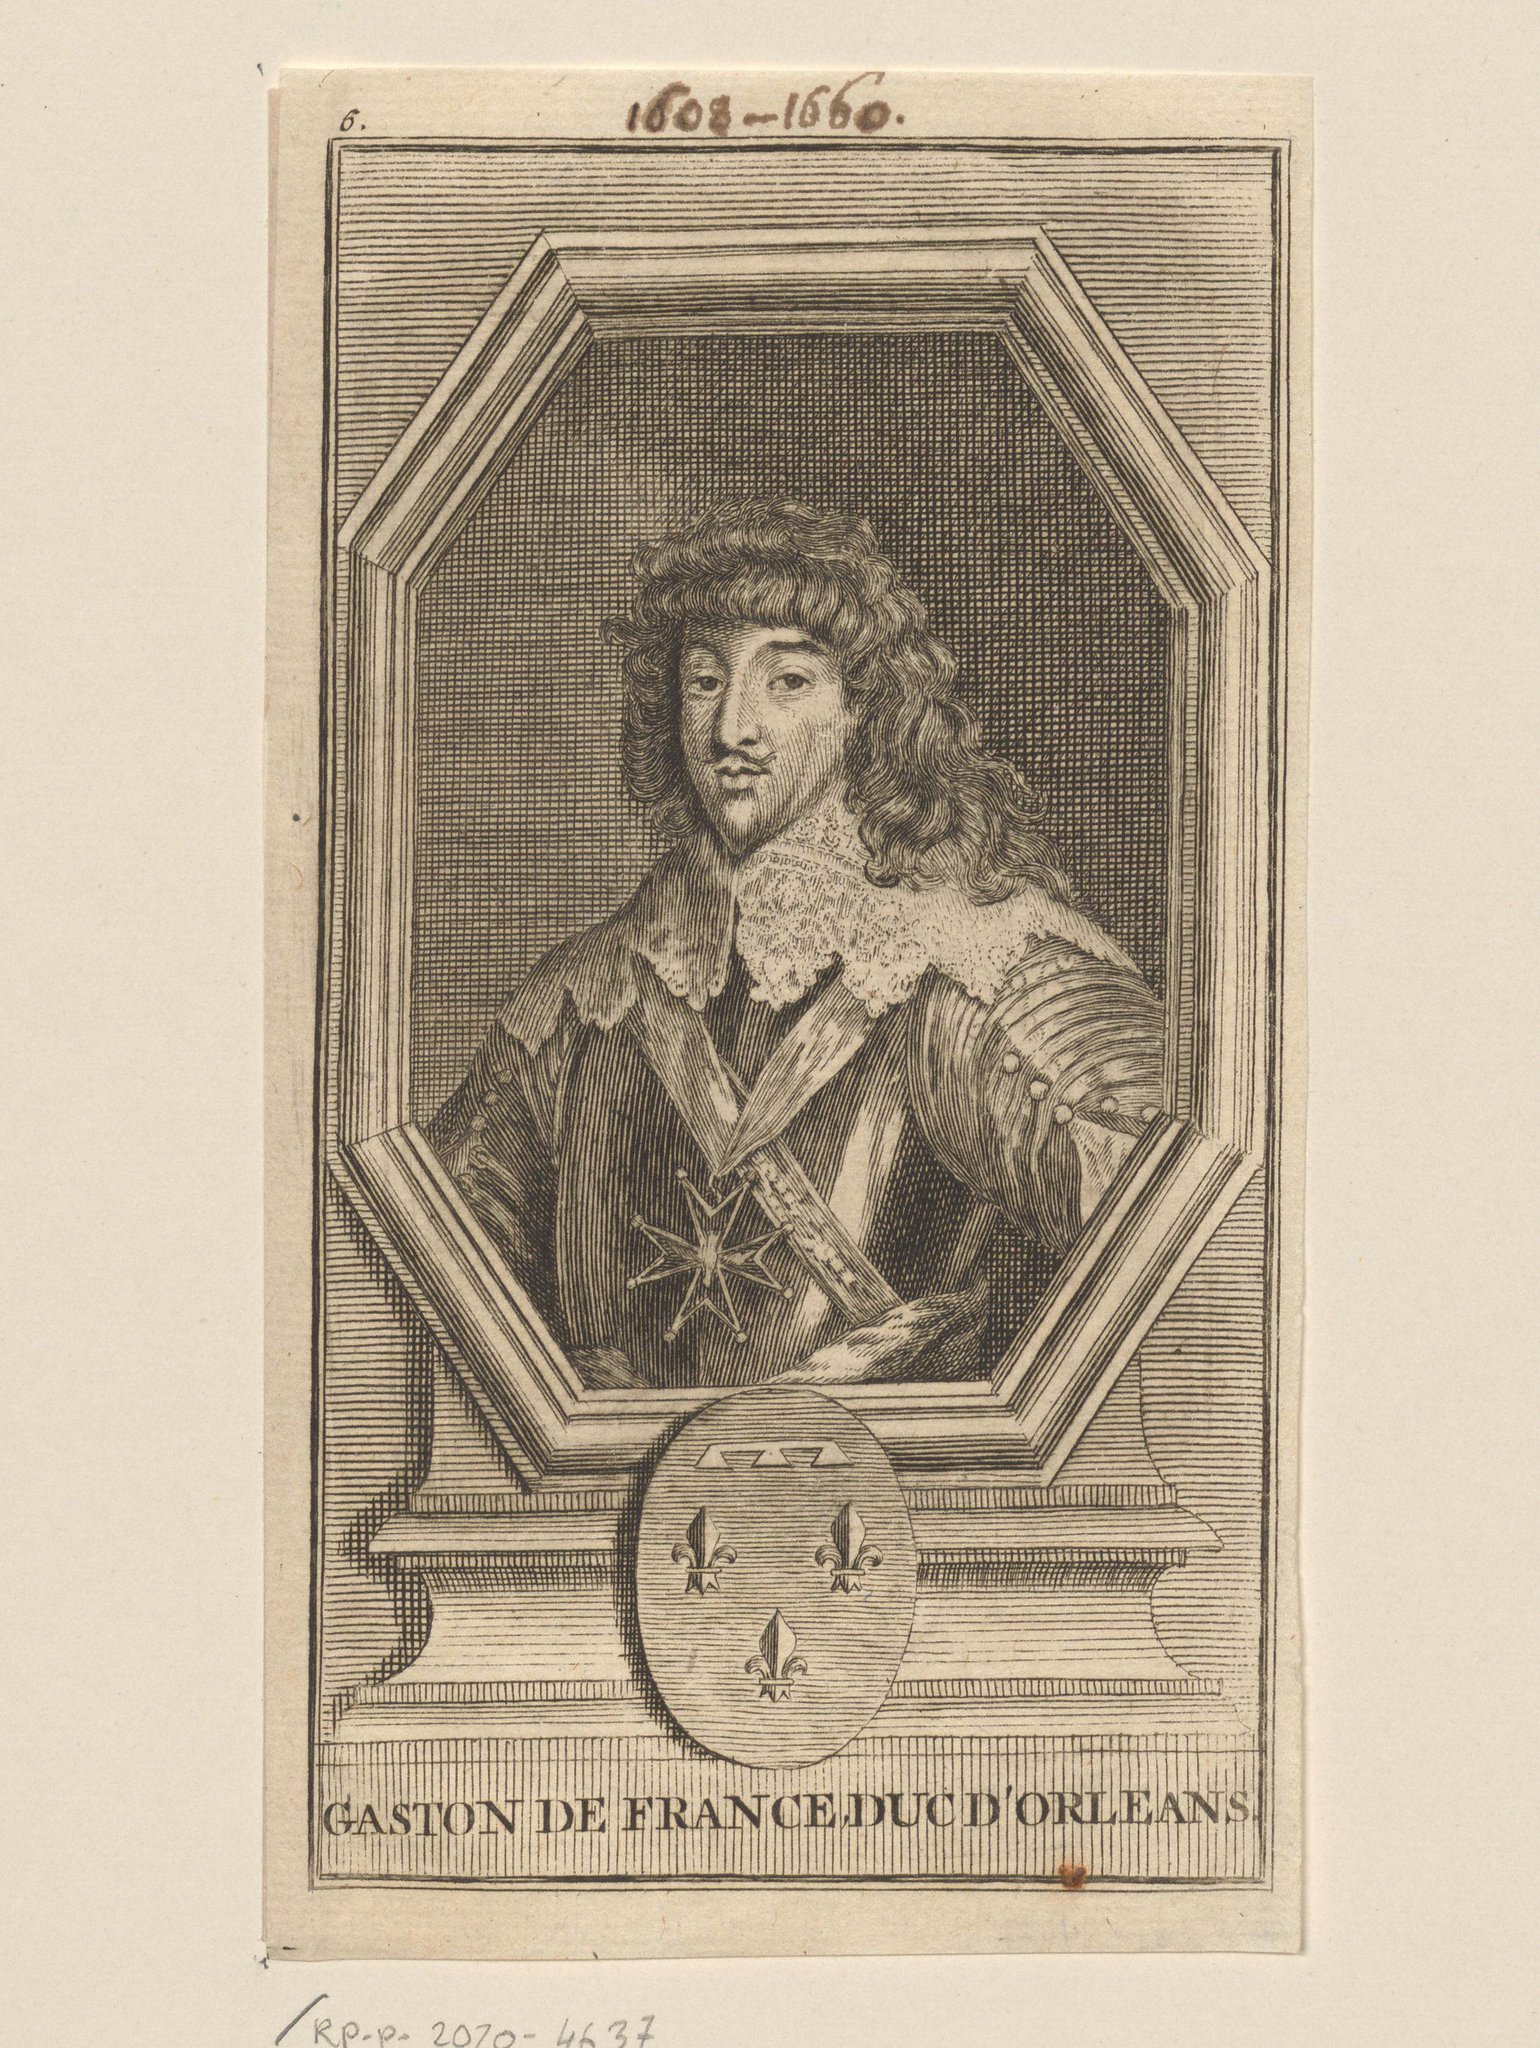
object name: print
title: Portret van Gaston Jean-Baptiste Orléans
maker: Anonymous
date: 1654-1660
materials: paper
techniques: engraving, etching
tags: gaston jean-baptiste hertog van orléans, historical persons